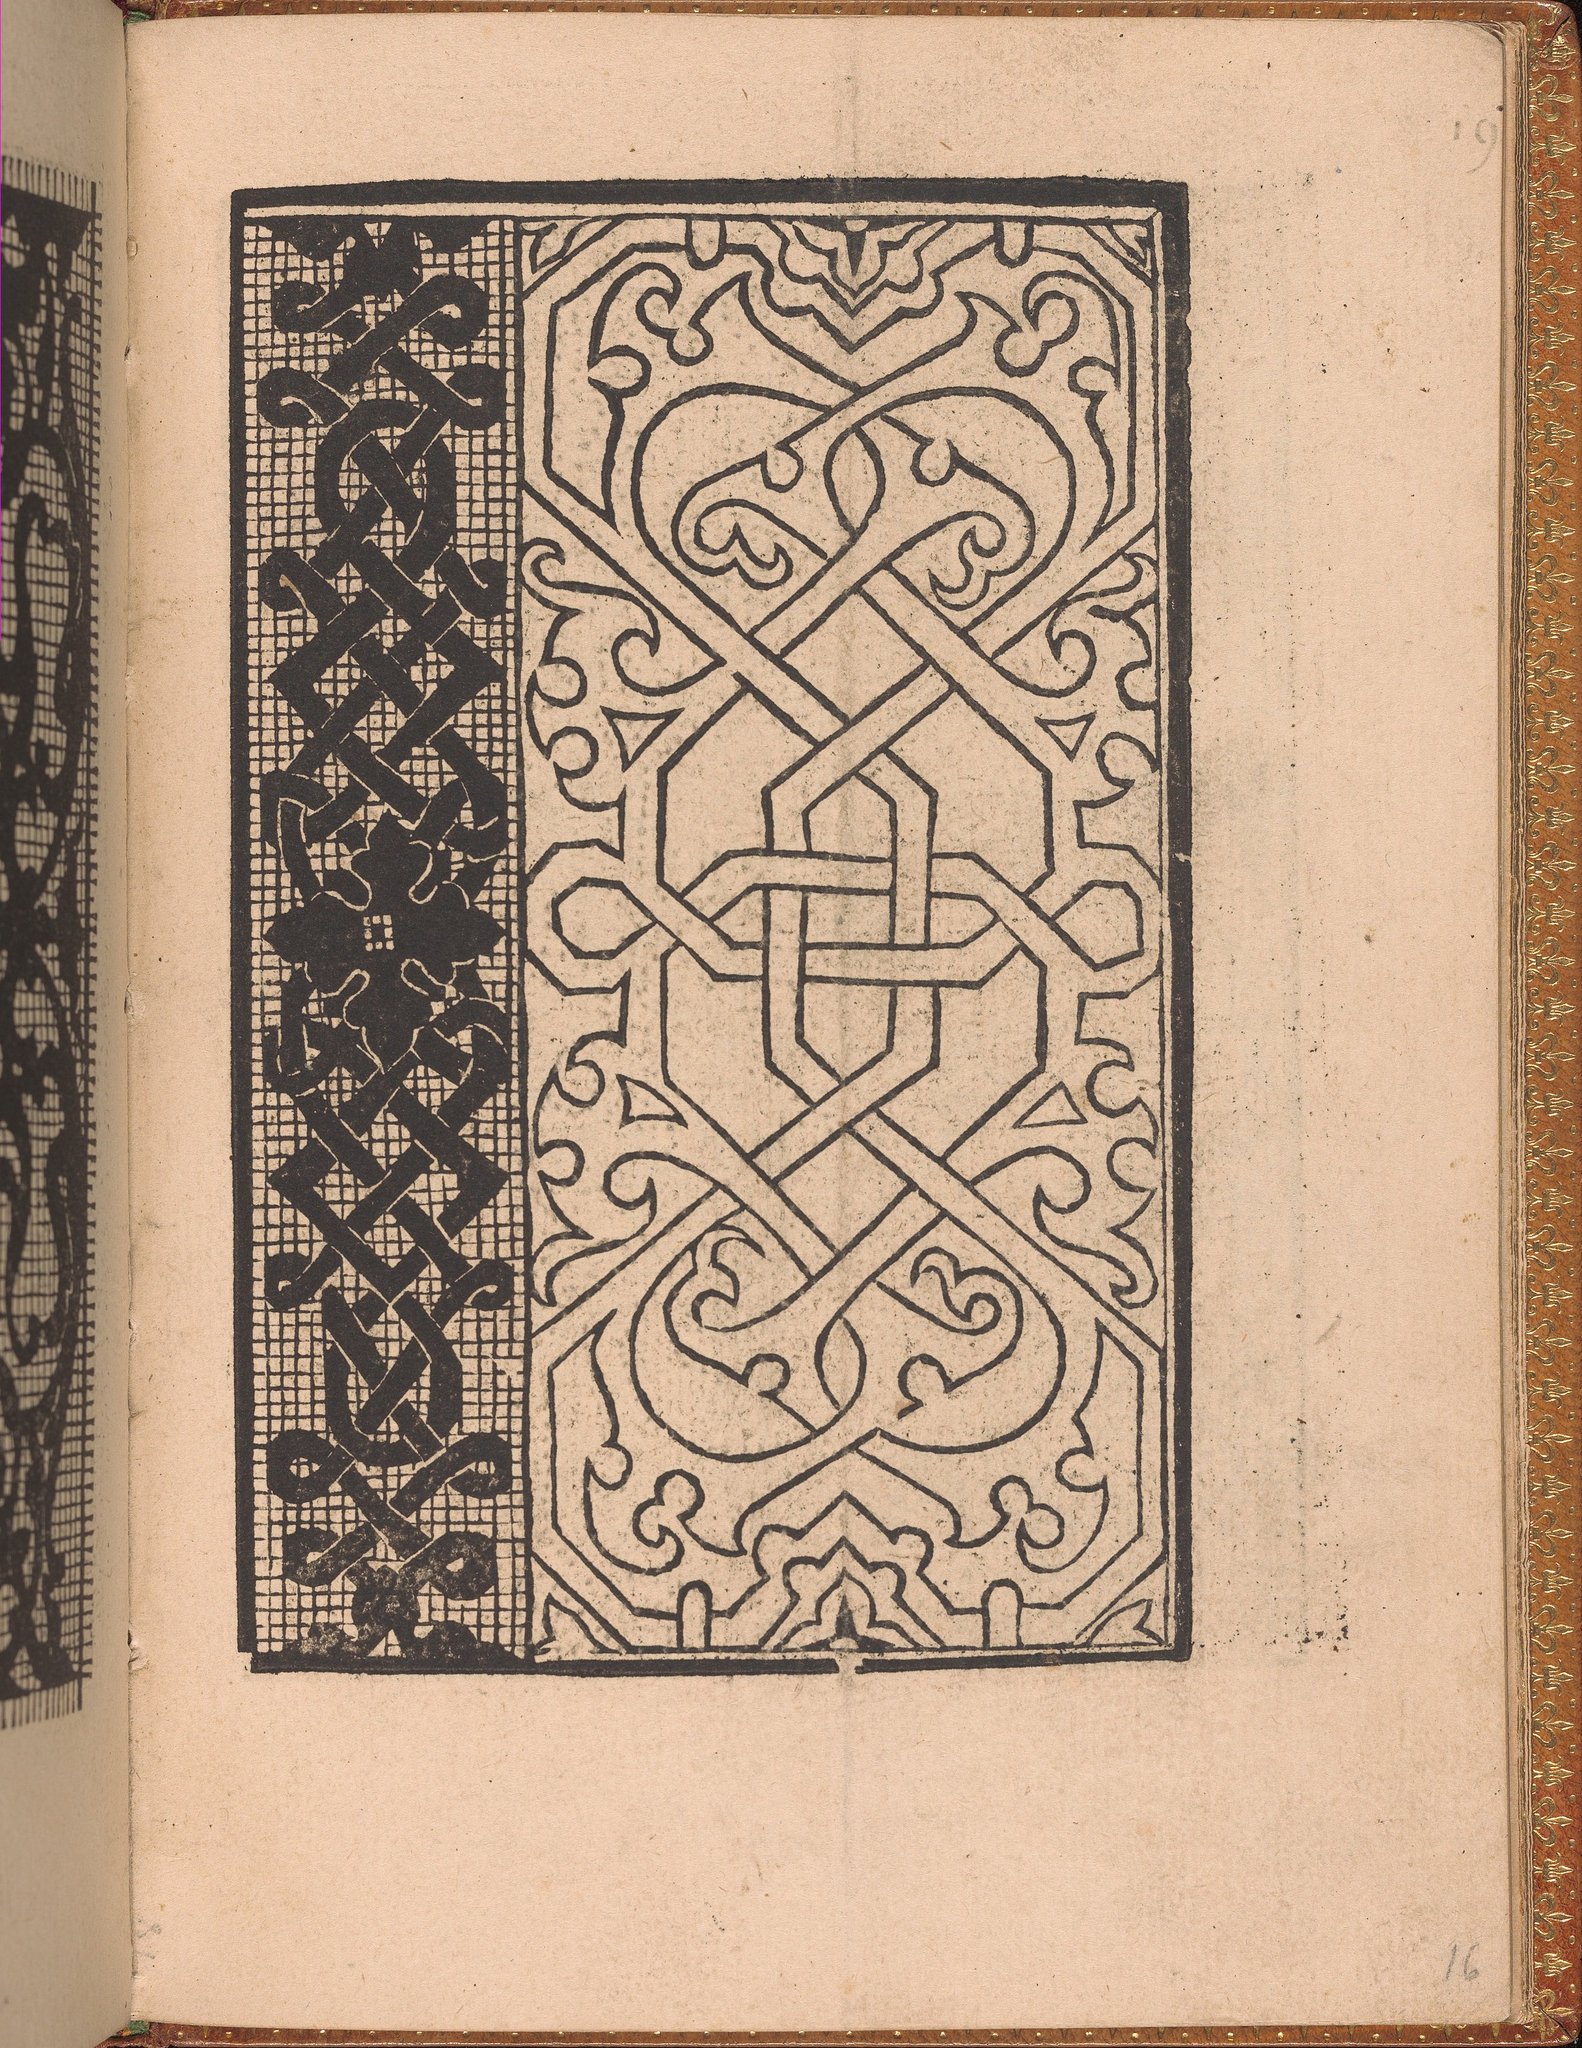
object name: book print ornament architecture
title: Convivio delle Belle Donne, page 16 (recto)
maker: nicolò zoppino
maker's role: publisher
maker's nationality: italian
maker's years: 1478-1544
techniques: woodcut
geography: italy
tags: flowers,vines